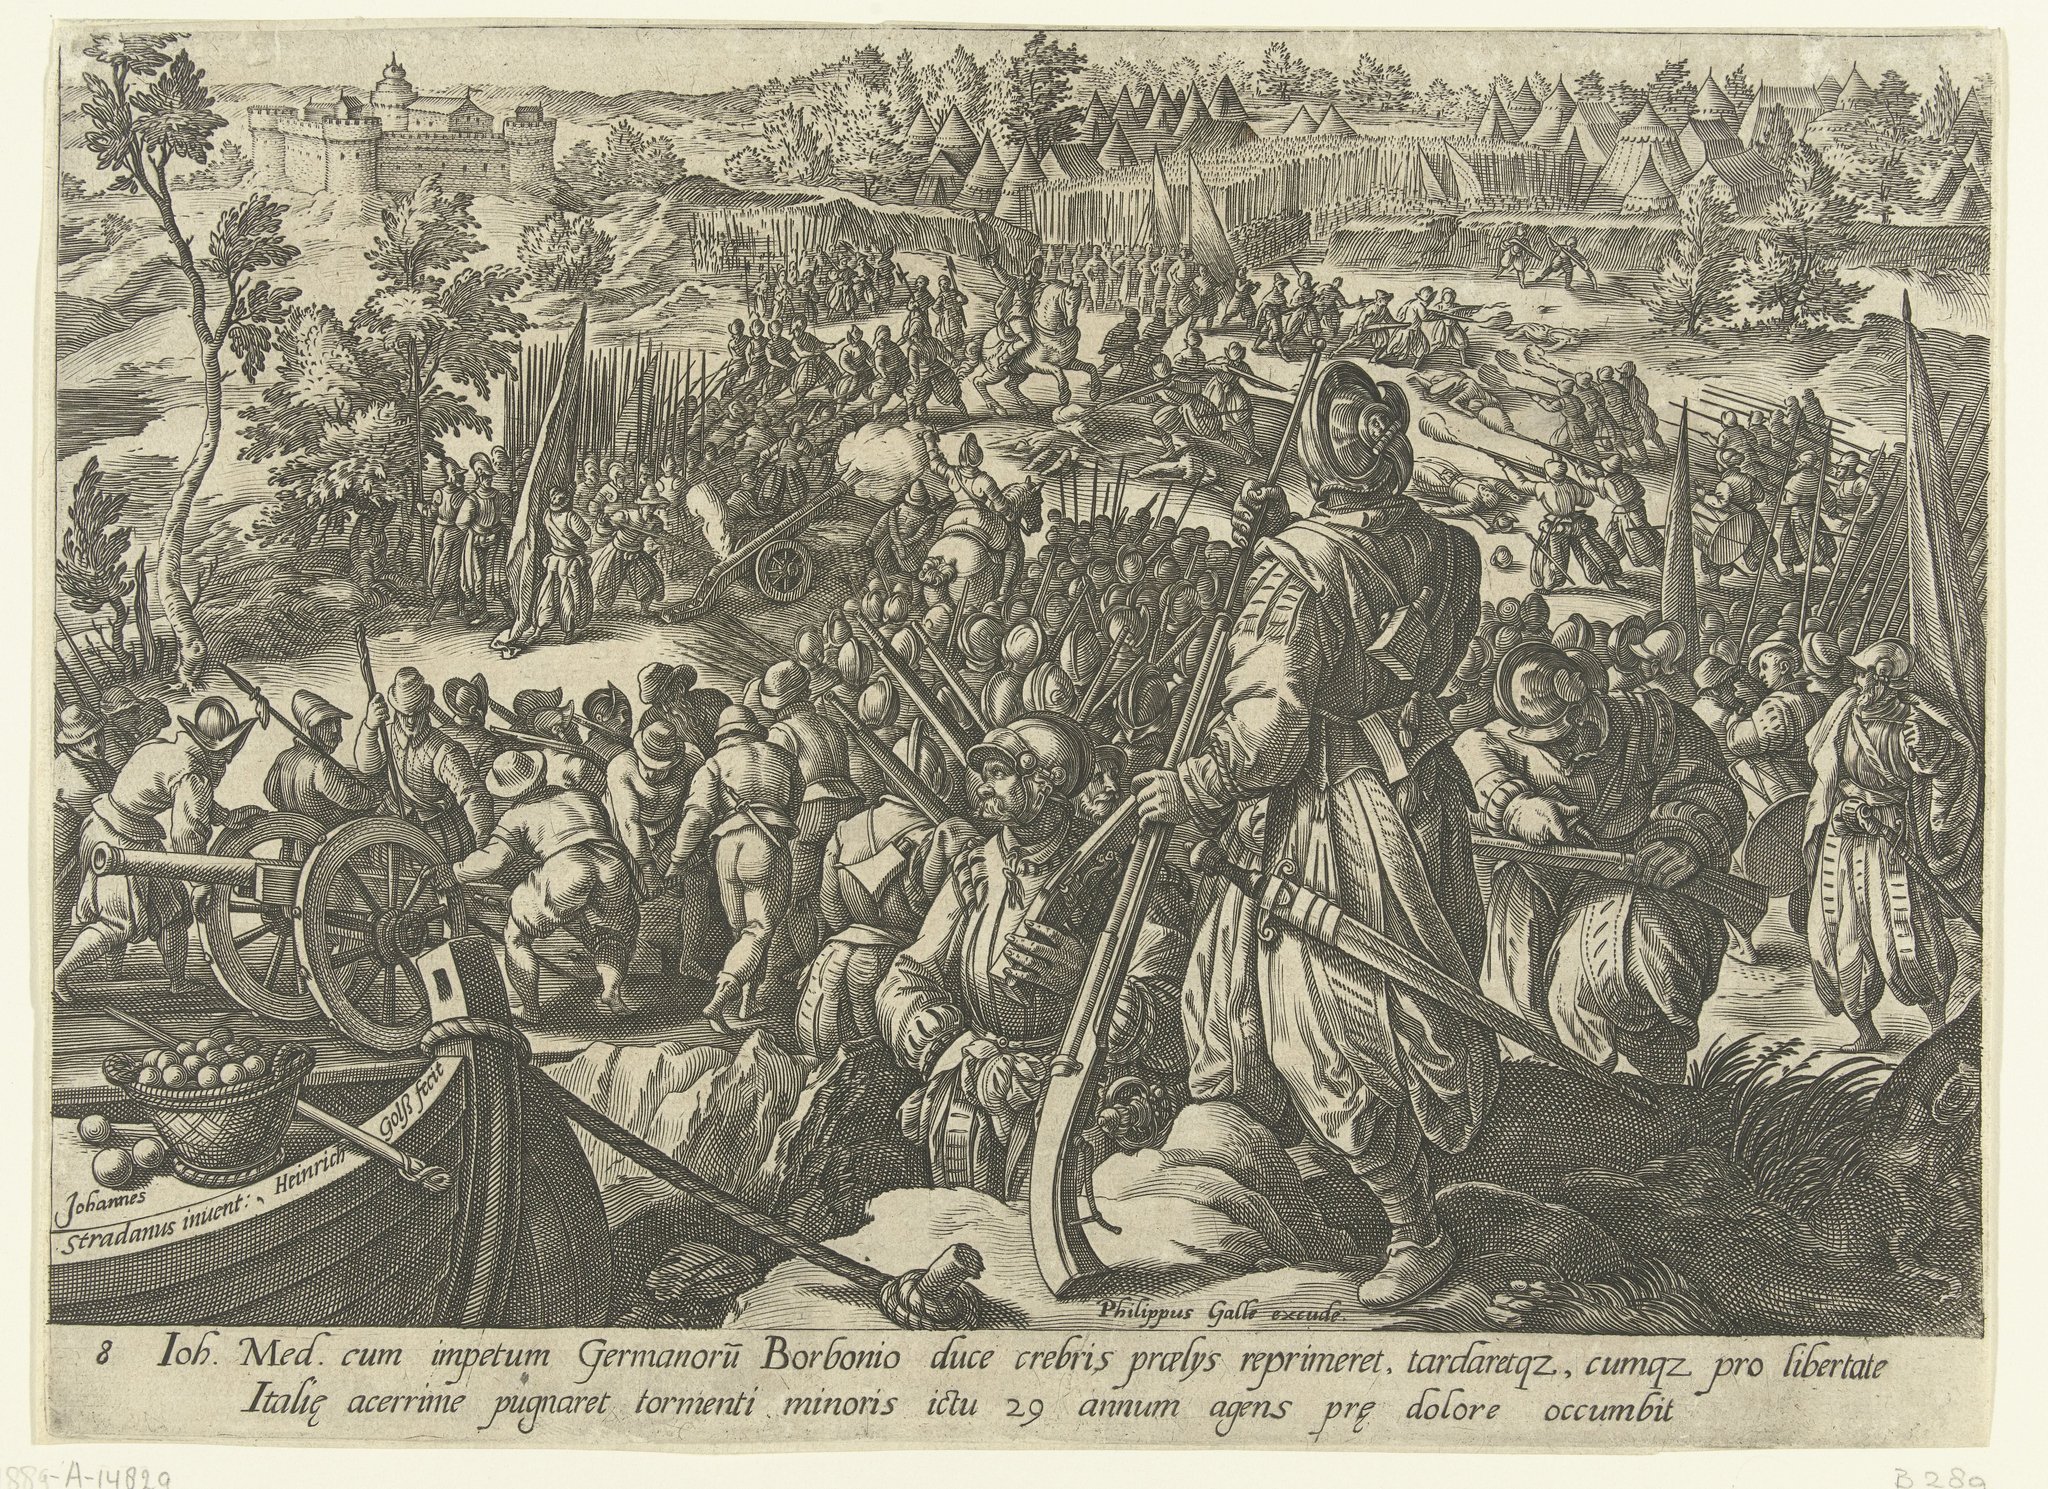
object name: print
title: Geschiedenis van Giovanni de' Medici (genoemd 'dalle Bande Nere')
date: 1576-1580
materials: paper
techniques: engraving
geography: haarlem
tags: battle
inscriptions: collector's mark: Lugt 2228a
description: Aanval op de troepen van Giovanni de' Medici nabij Mantua. Tijdens deze strijd raakte Giovanni dodelijk gewond. Op de achtergrond rechts een legerkamp, links een burcht. Onder de voorstelling twee regels Latijn. Deze prent is onderdeel van een 22-delige reeks prenten van de geschiedenis van Giovanni de' Medici, genoemd 'dalle Bande Nere'.